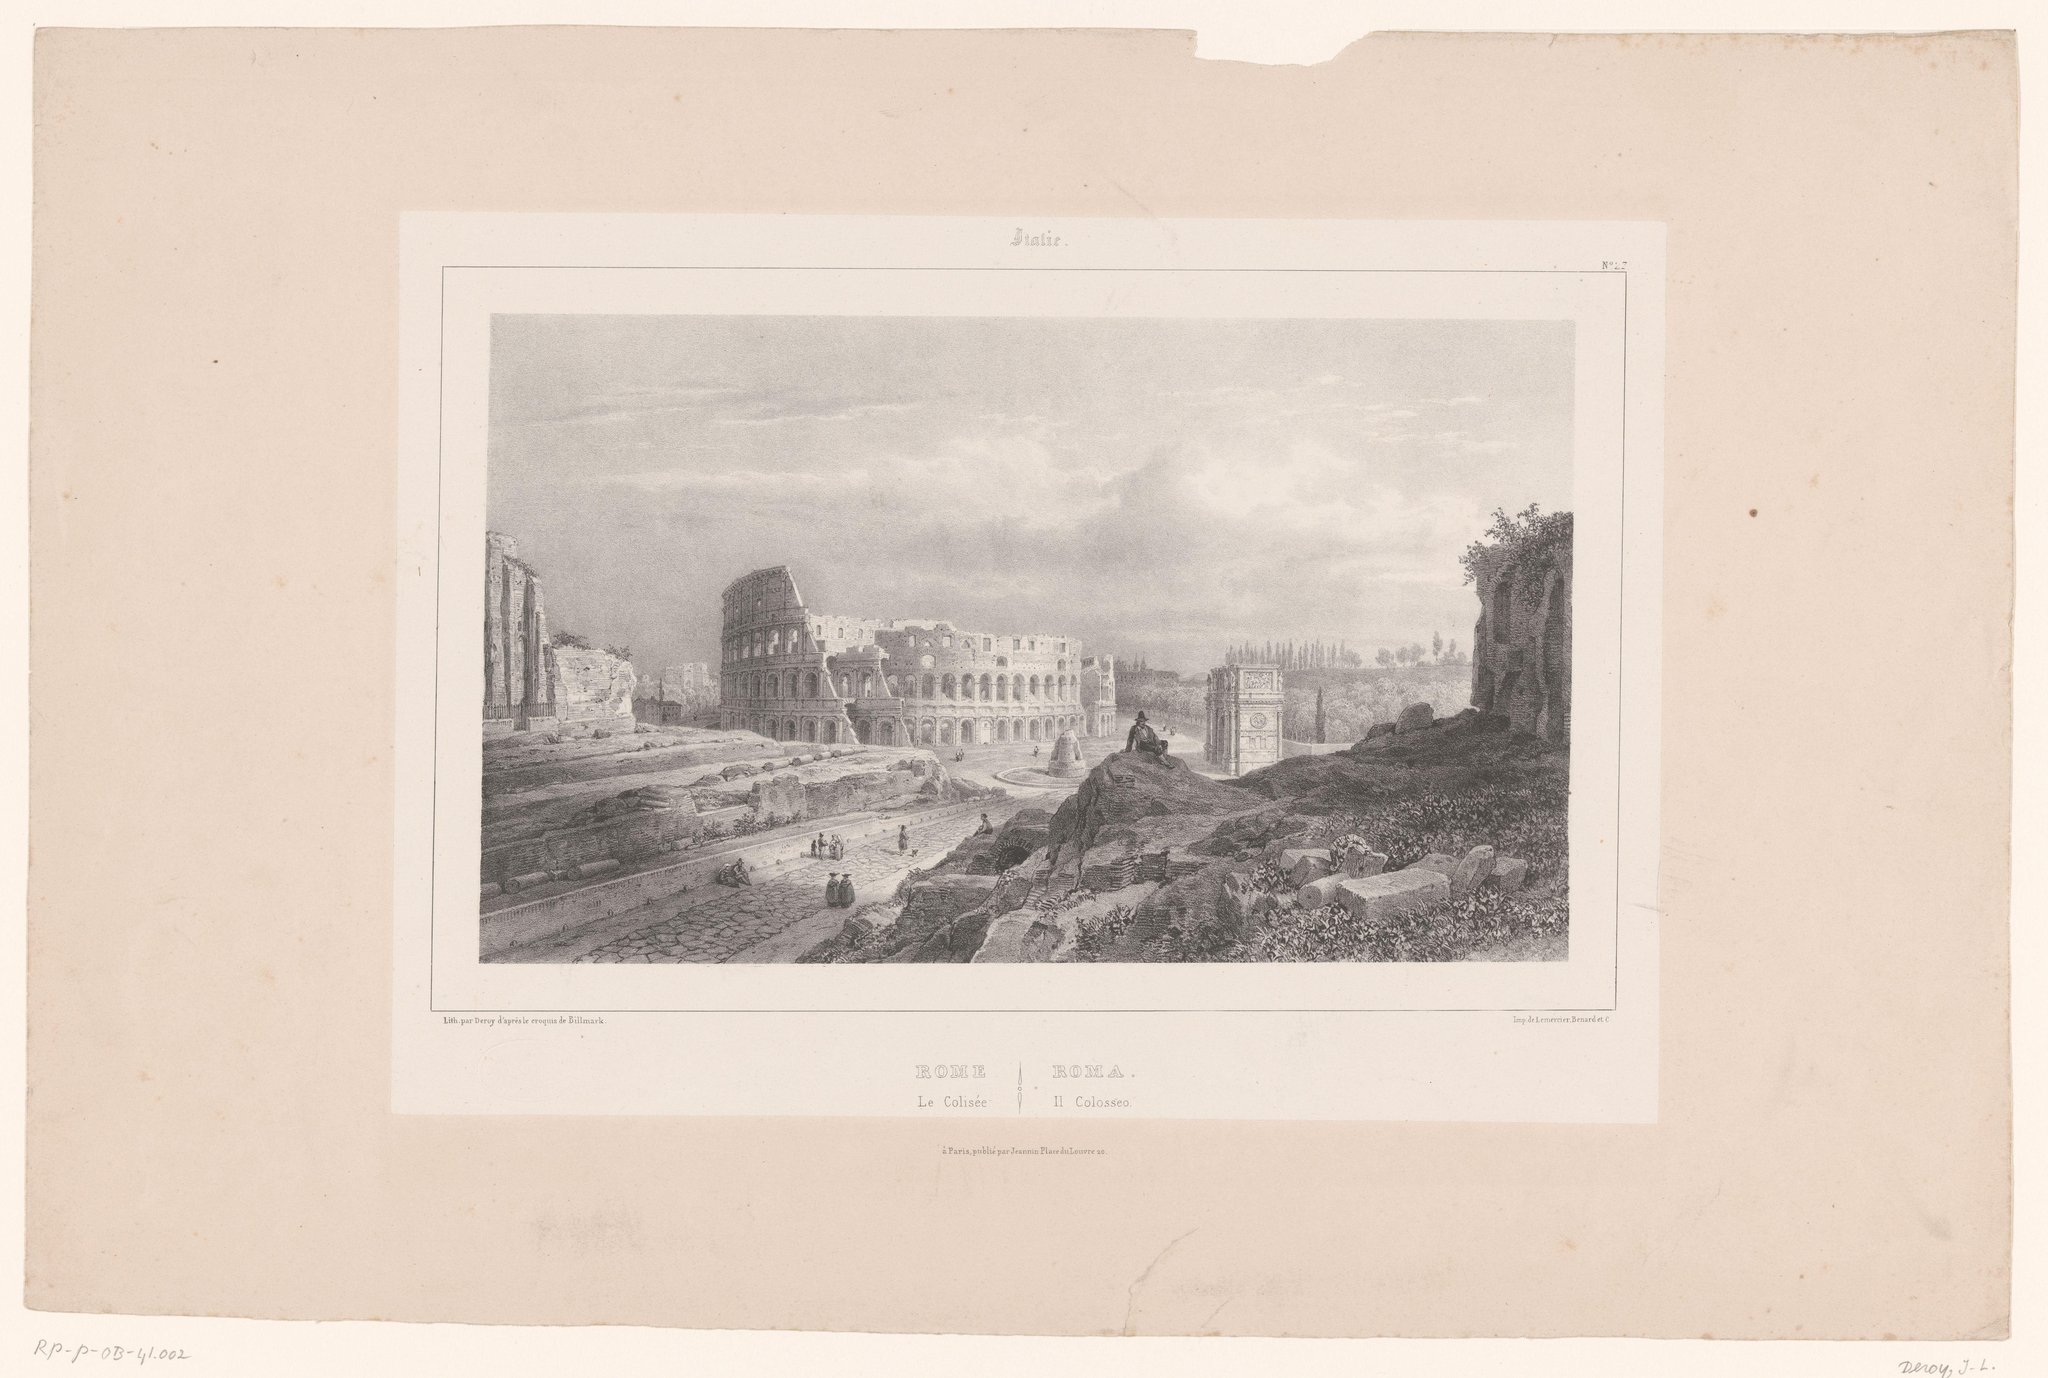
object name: print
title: Rome. Le Colisée / Roma. Il Colosseo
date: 1838-1841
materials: paper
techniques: lithograph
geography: paris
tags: ruin of a building ~ architecture, amphitheatre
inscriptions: check stamp: Lugt 1397c